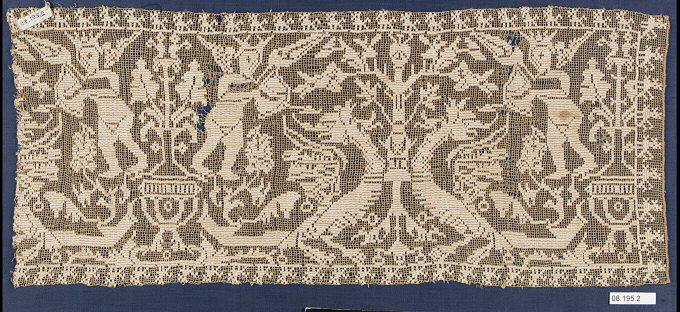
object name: fragment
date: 1501-1600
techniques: embroidery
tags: human figures